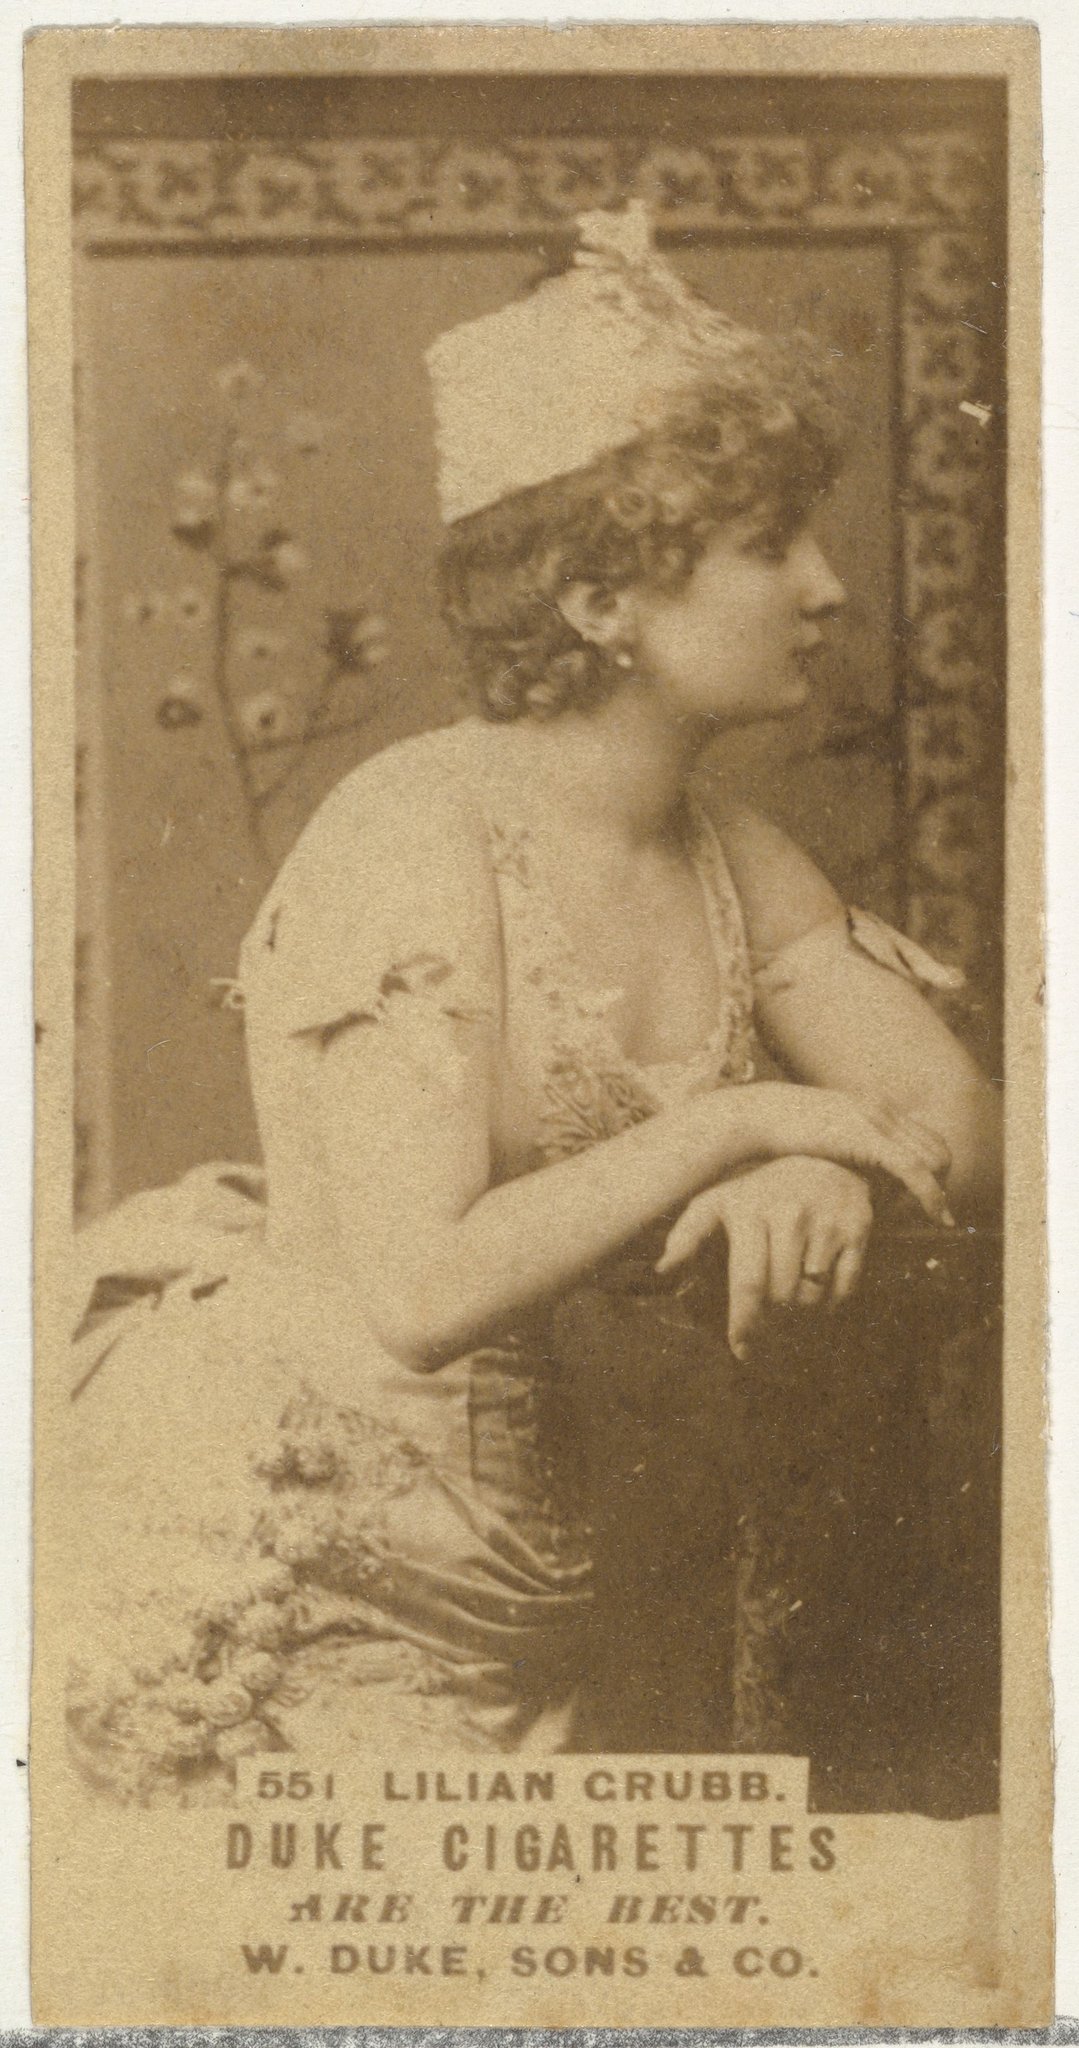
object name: photograph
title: Card Number 551, Lillian Grubb, from the Actors and Actresses series (N145-7) issued by Duke Sons & Co. to promote Duke Cigarettes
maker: w. duke, sons & co.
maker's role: publisher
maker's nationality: american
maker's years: 1870-1920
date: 1880-1889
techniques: albumen silver print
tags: women,actresses